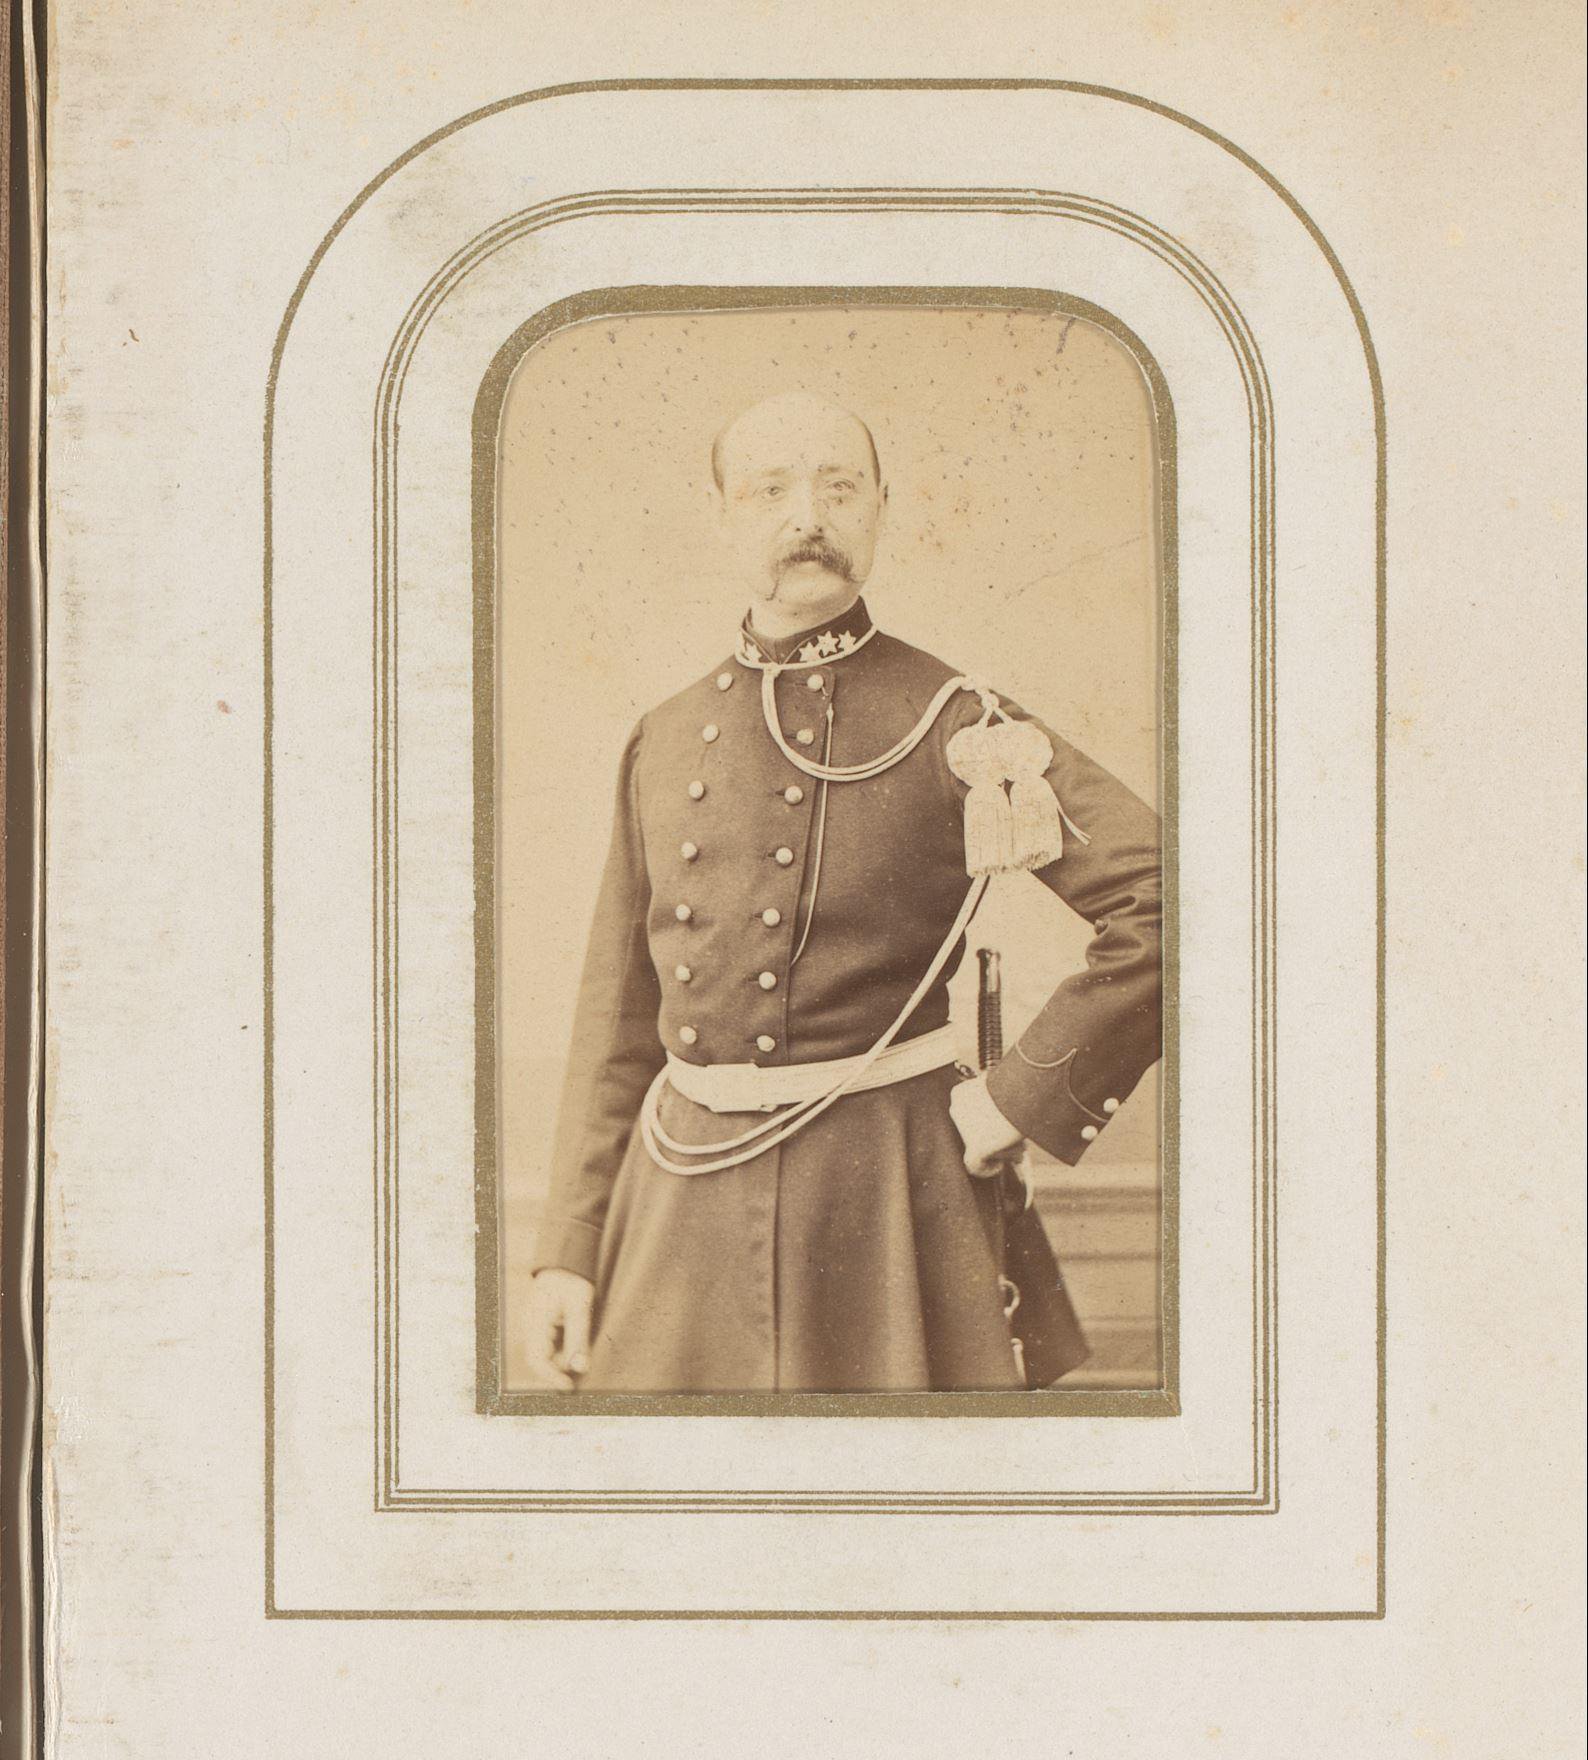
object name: carte de visite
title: Portret van een man met snor in uniform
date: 1867-1871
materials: cardboard, photographic support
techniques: albumen print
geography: belgium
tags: moustache, historical persons, (military) uniforms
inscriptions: inscription: ‘Daveluy & Fils/ Photographes/ Bruges et Ostend/ Mention Honorable à l'Exposition Universelle de/ Paris 1867’